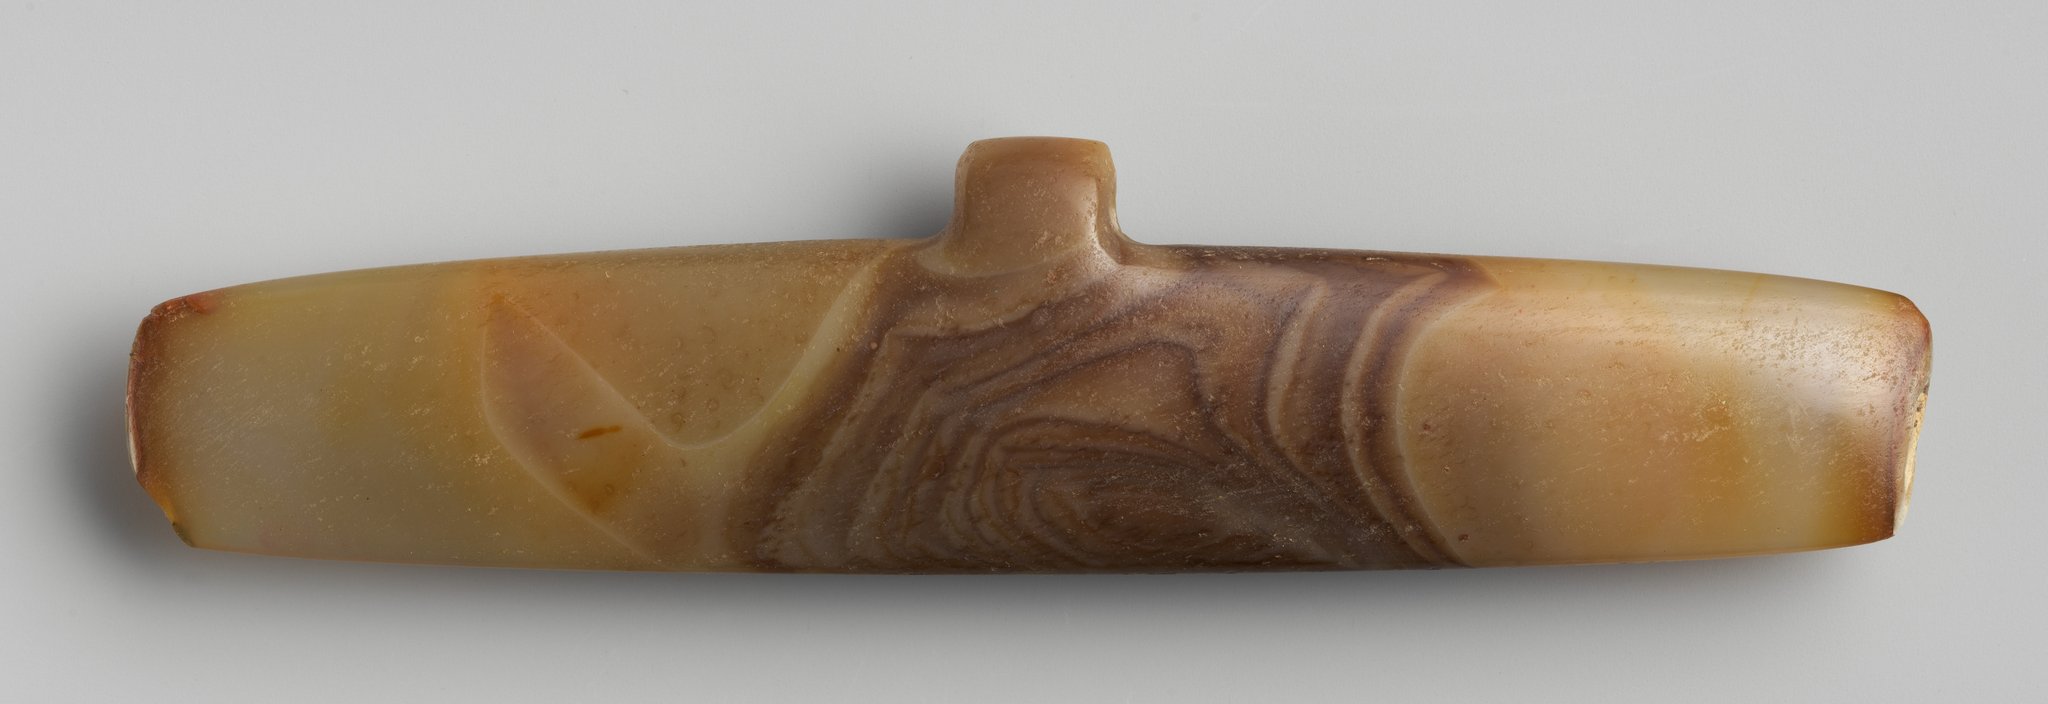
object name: pendant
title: Winged Pendant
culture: coclé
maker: coclé artist(s)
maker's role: artist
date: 700-1000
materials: stone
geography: panama